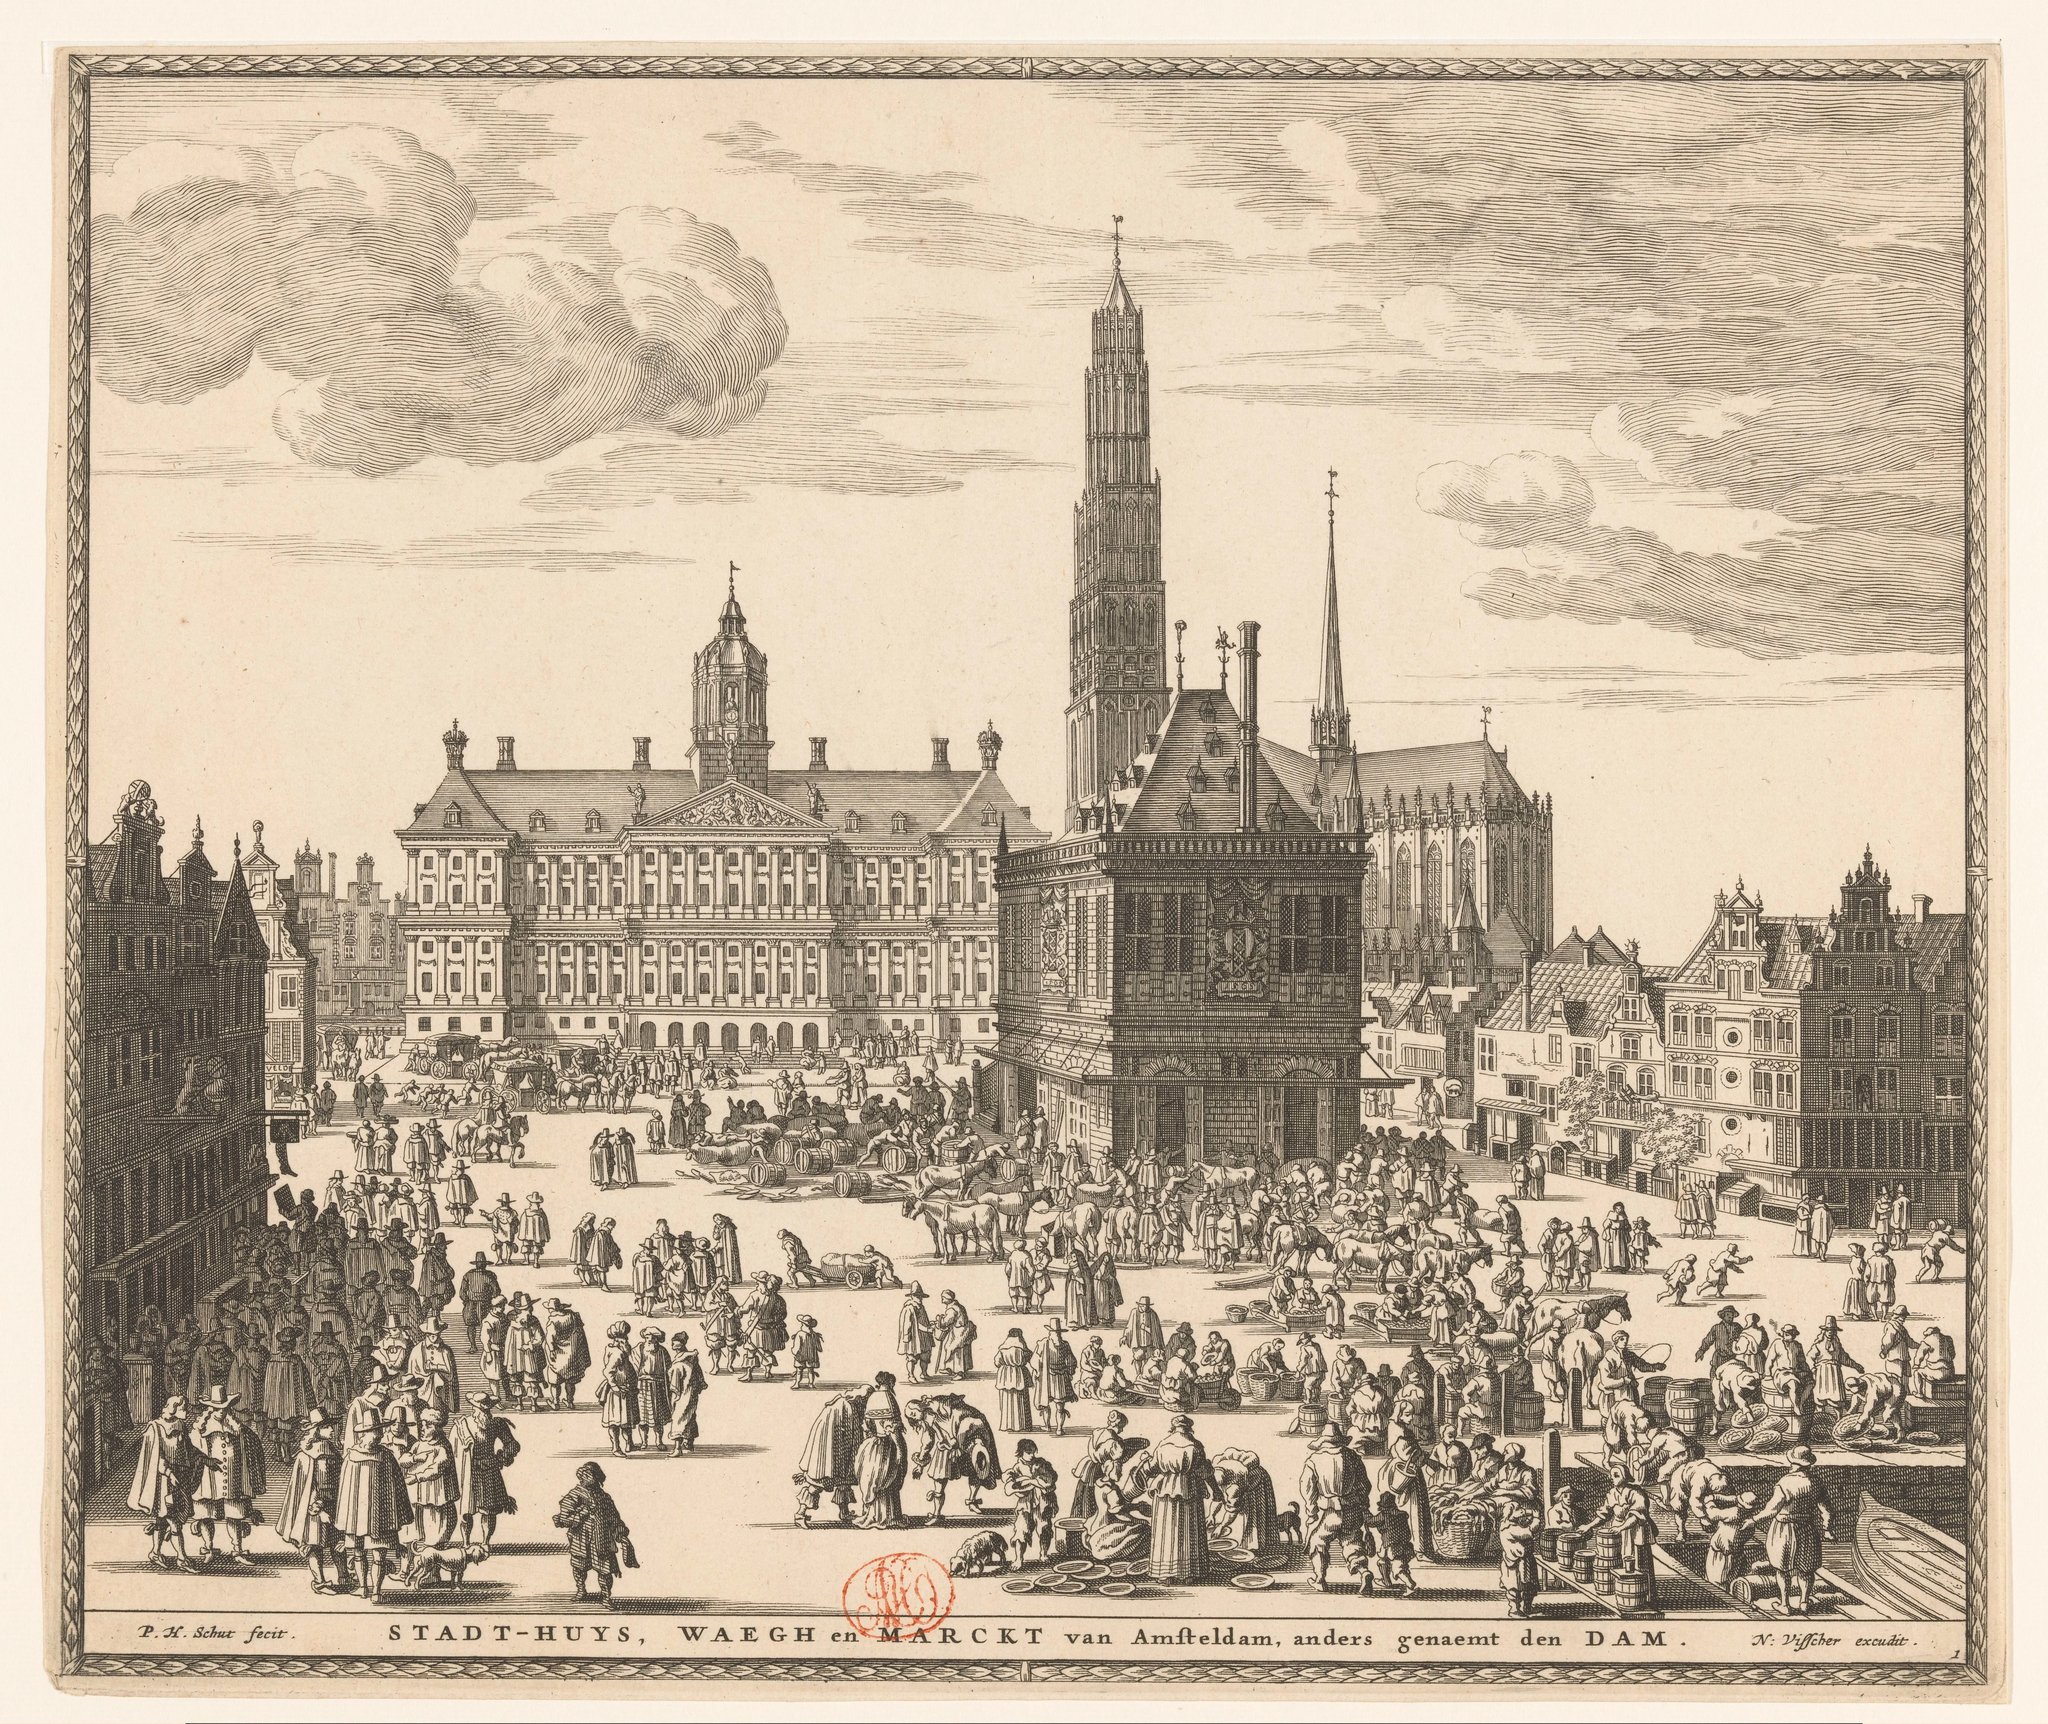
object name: print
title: Acht gebouwen in Amsterdam (Schut / Visscher)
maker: pieter hendricksz. schut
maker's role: print maker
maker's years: 1618-1660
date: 1662-1720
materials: paper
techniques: engraving, etching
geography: amsterdam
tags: church (exterior), townhall, weigh-house, parts of church exterior and annexes: tower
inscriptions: collector's mark: Lugt 195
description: Gezicht op de Dam te Amsterdam. Links van het midden het Stadhuis. Rechts van het midden de Nieuwe Kerk met de nooit voltooide toren, daarvoor de Waag. Rechtsonder genummerd: 1.